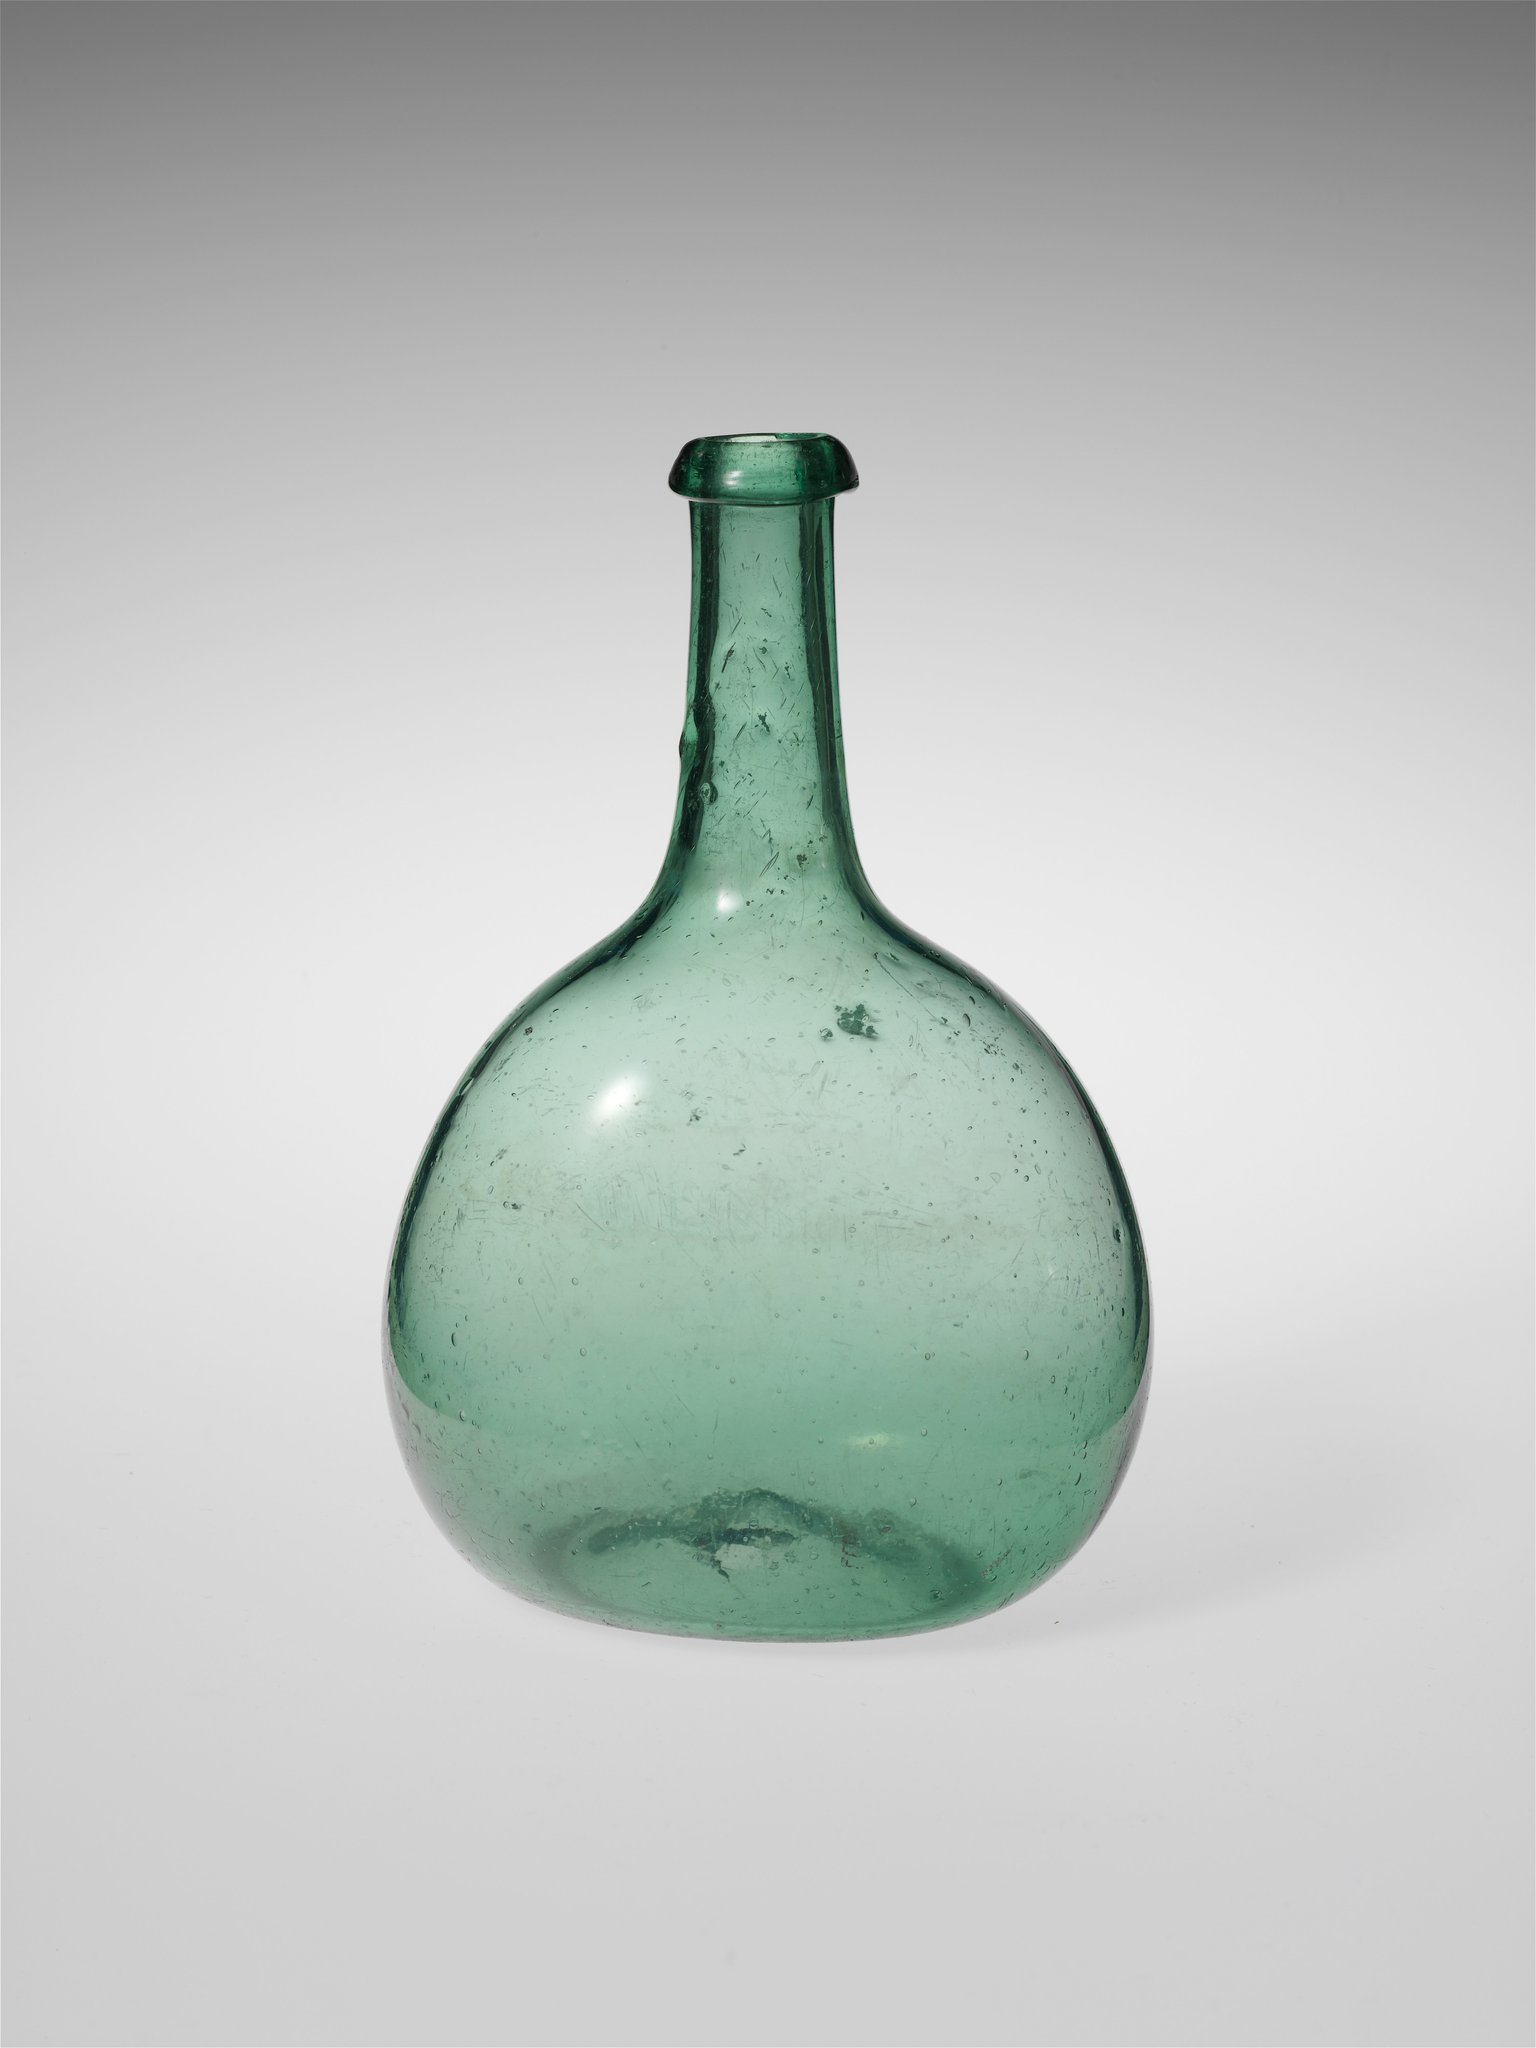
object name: bottle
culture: american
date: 1801-1900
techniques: glassblowing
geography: united states